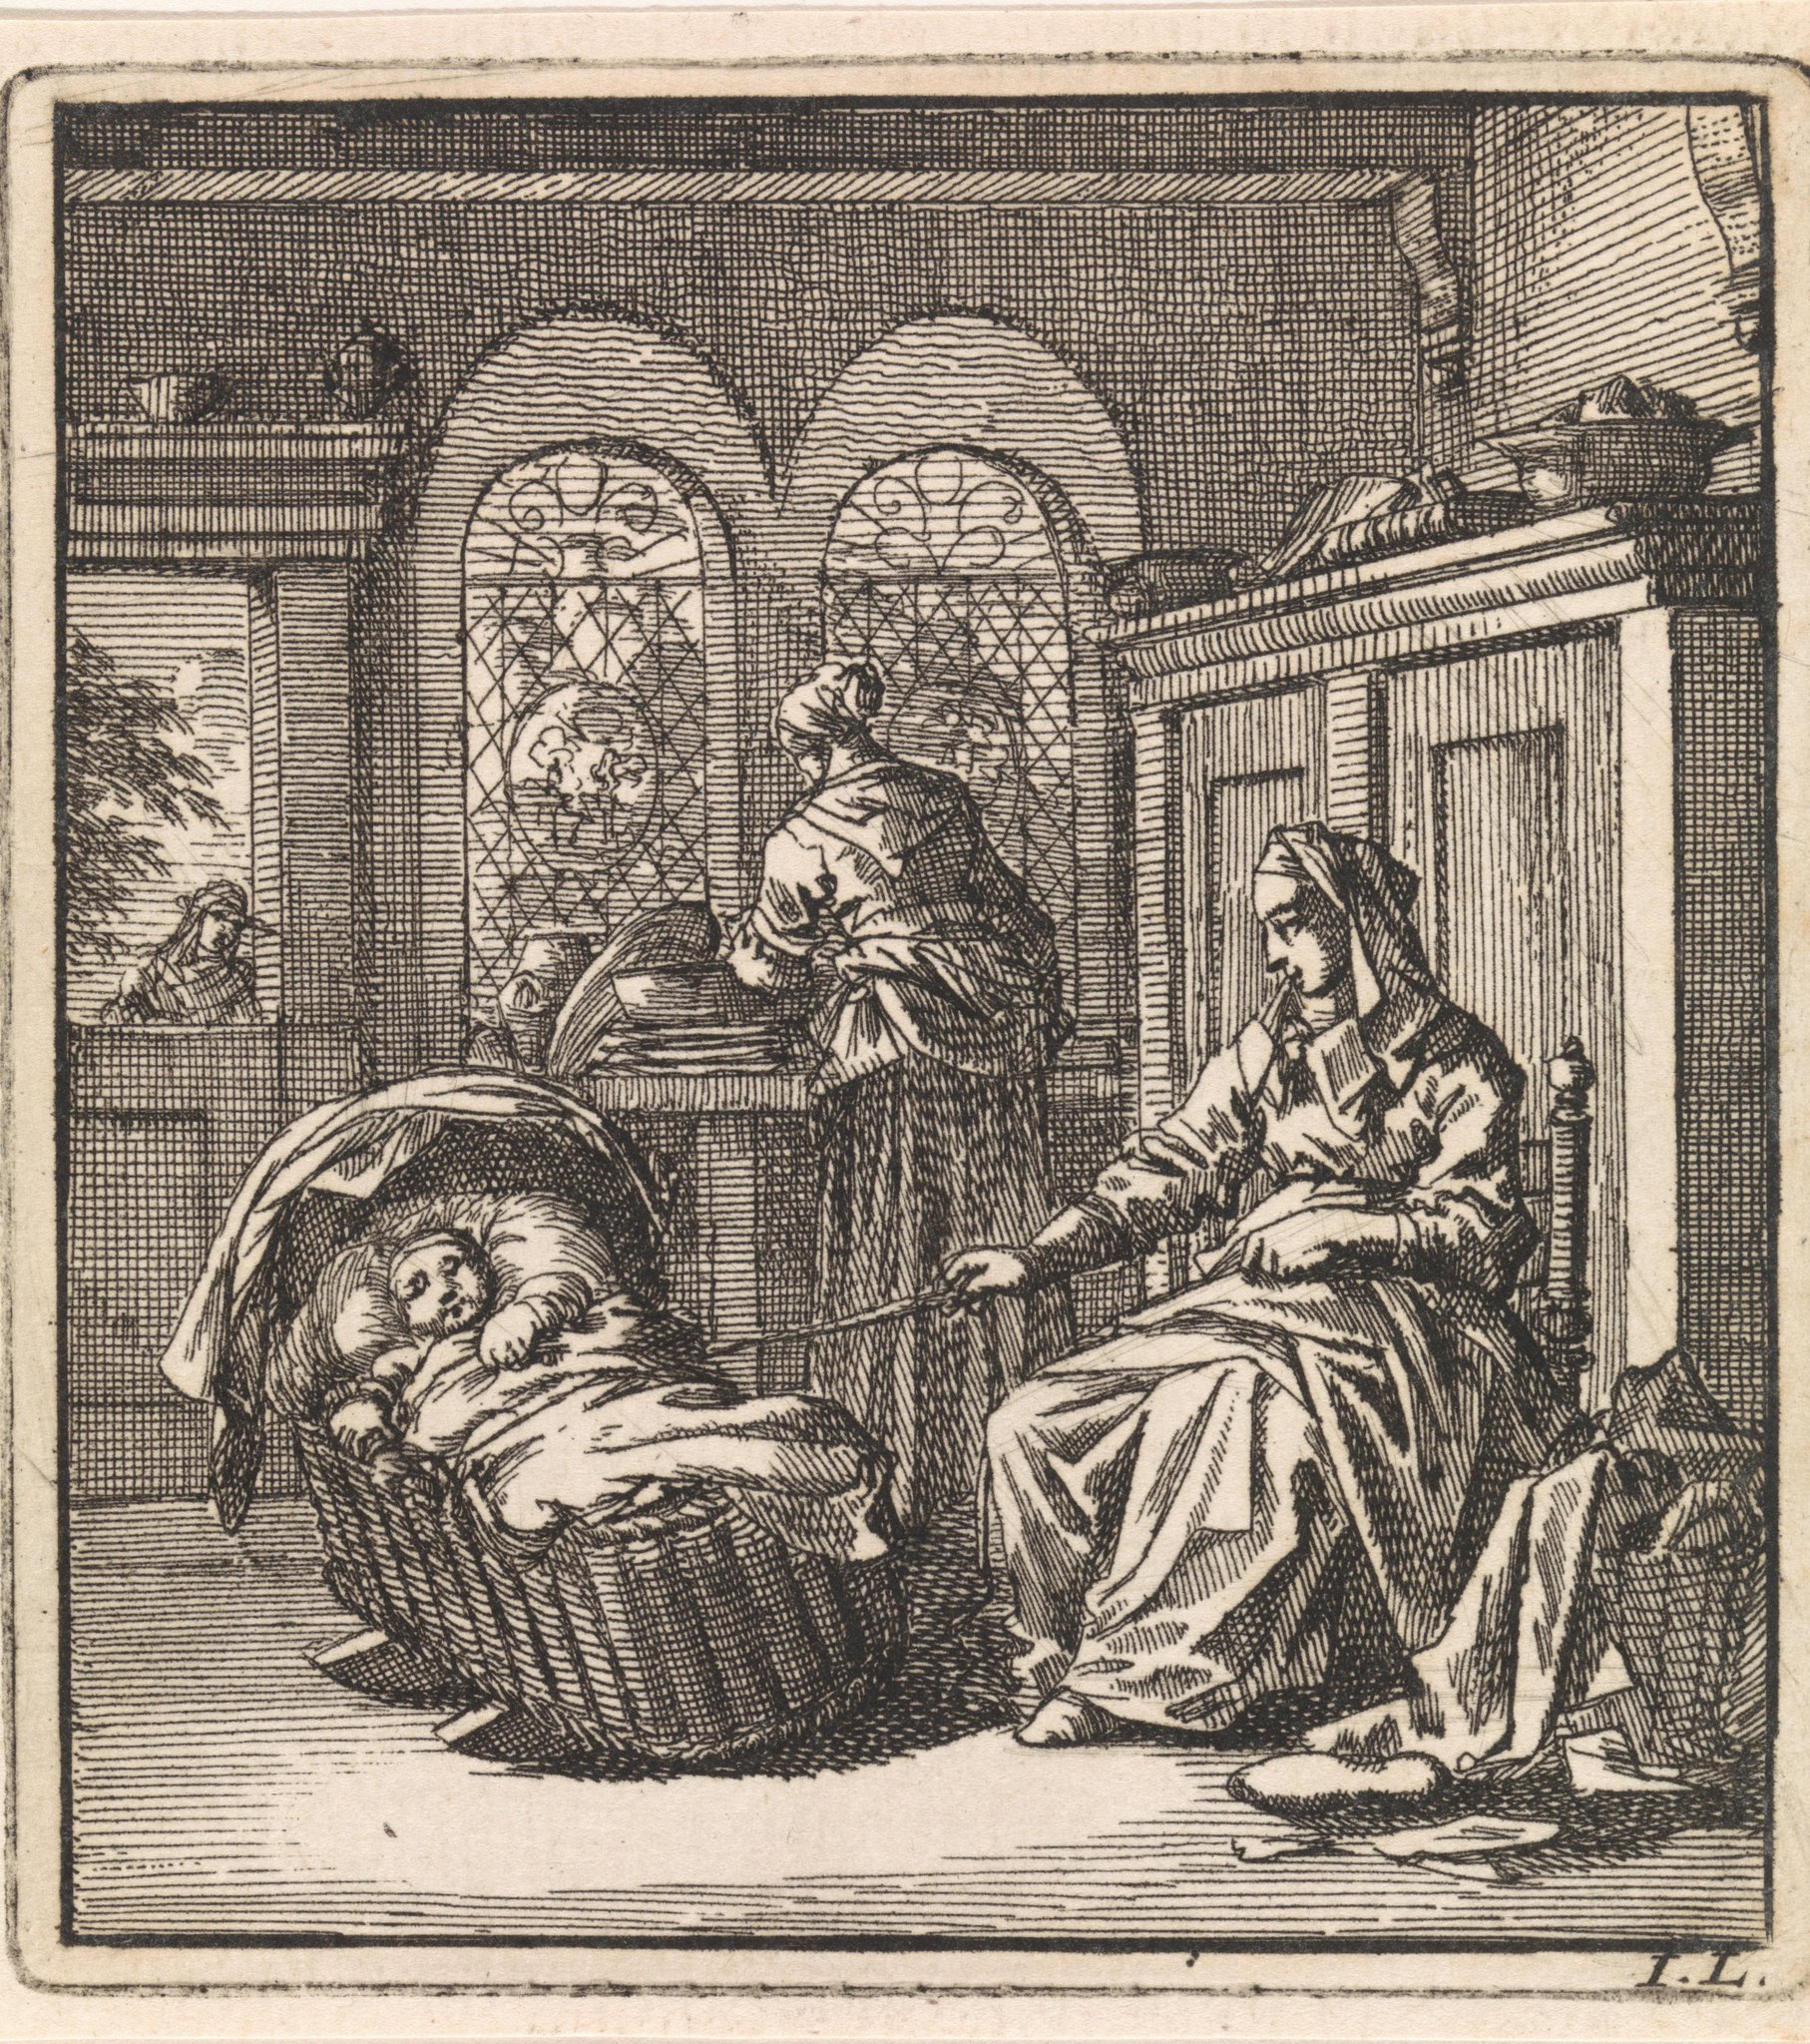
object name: book illustration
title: De Wieg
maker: jan luyken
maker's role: draughtsman, print maker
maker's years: 1649-1712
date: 1711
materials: paper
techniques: etching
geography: amsterdam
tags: cradle, crib, washing up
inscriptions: collector's mark: Lugt 2228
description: Illustratie voor: Luyken, Jan. Het leerzaam huisraad, vertoond in vyftig konstige figuuren, met godlyke spreuken en stichtelyke verzen: Pieter Arentsz. II (wed.) en Cornelis van der Sys, 1711, p. 110.